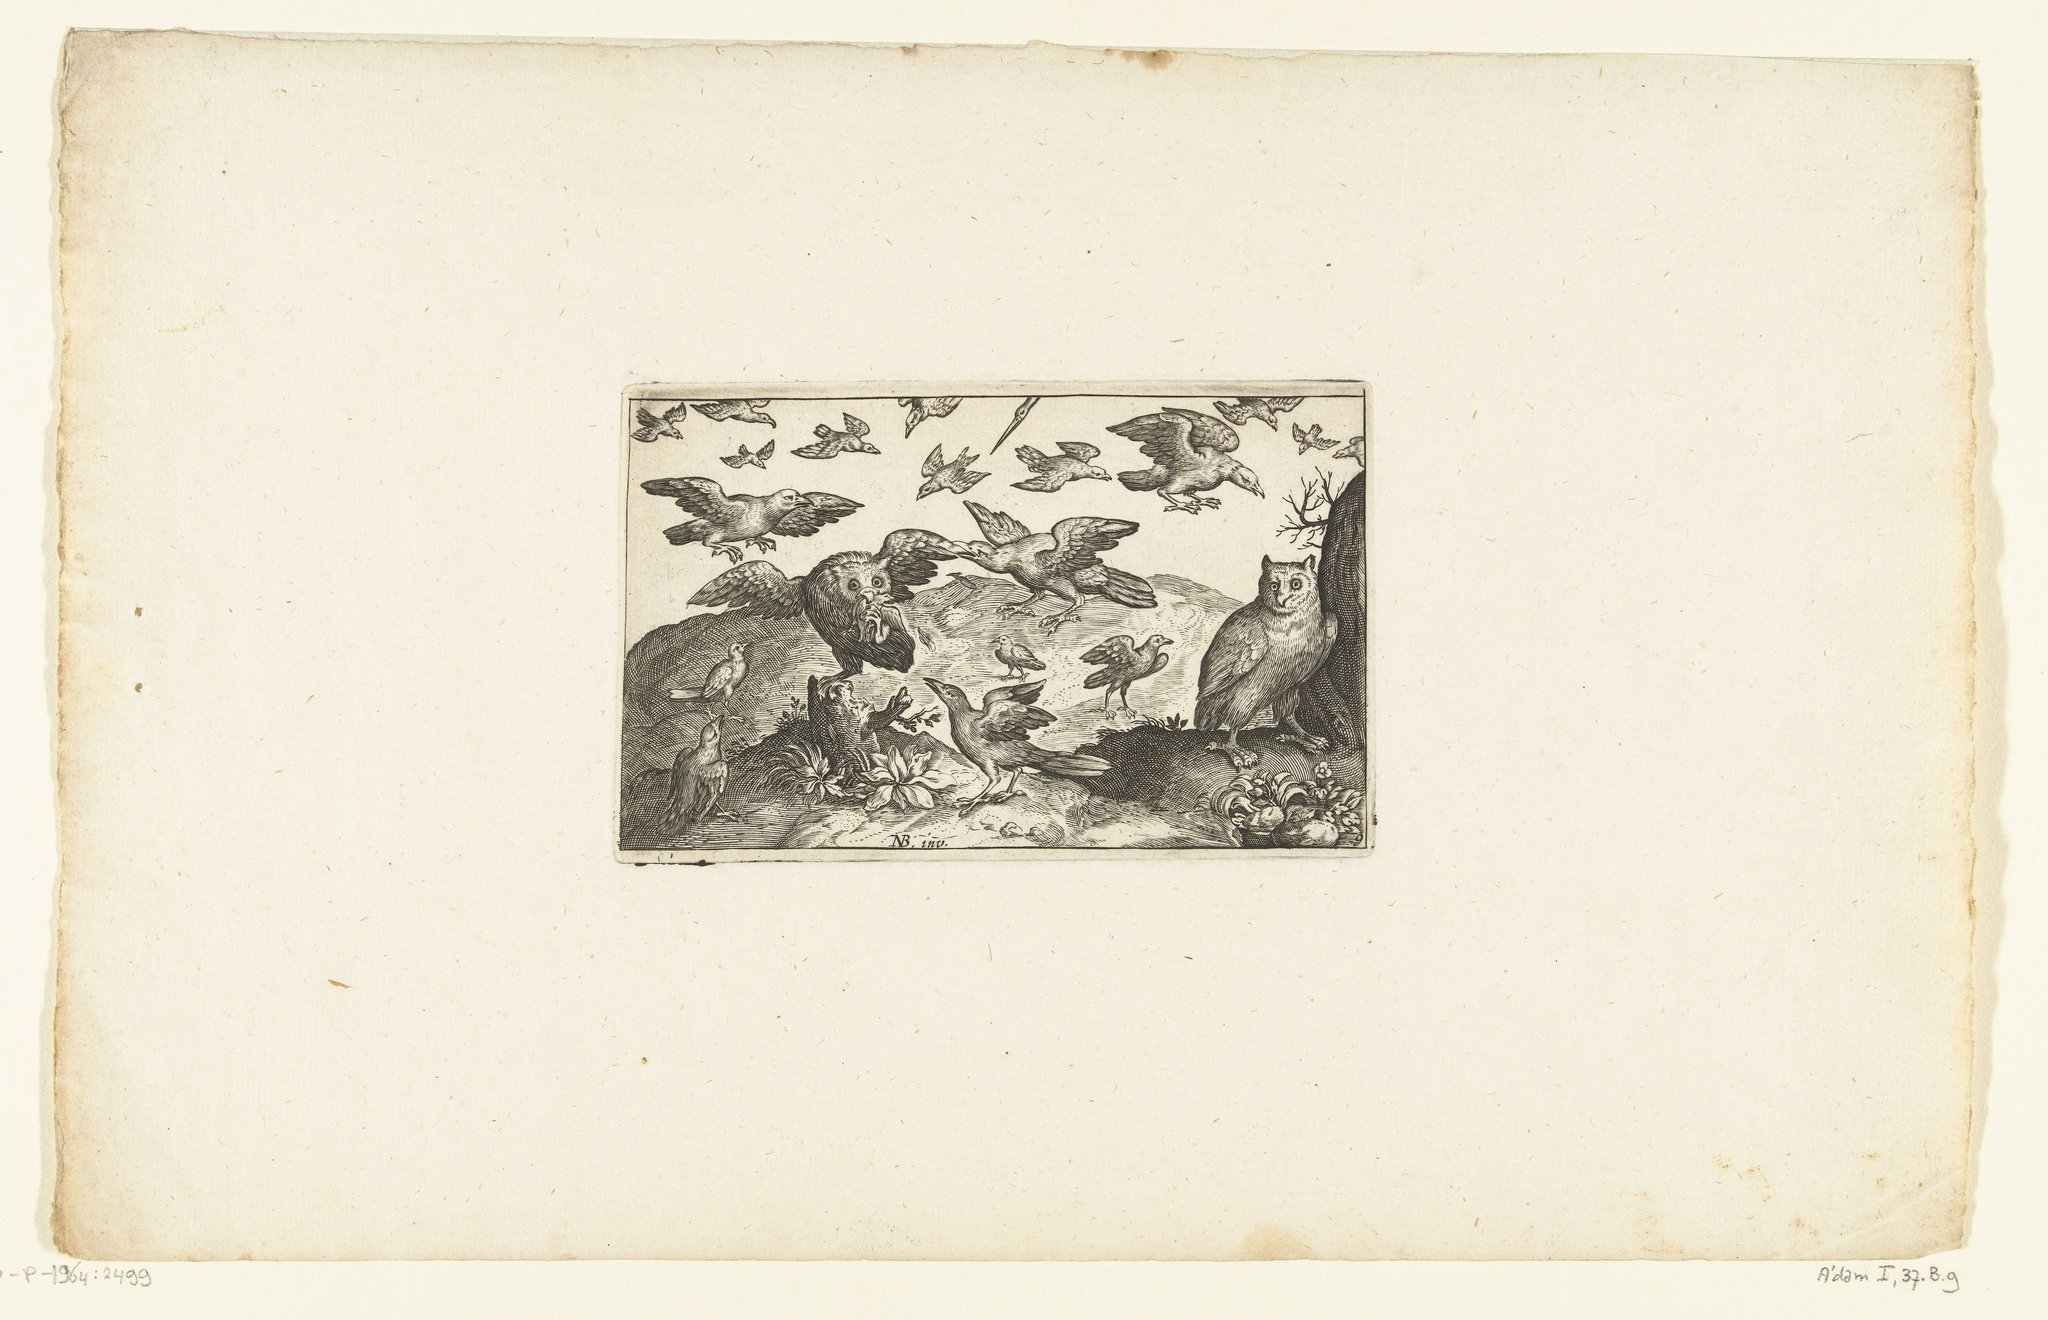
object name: print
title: Staande uil en uil die belaagd wordt door vogels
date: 1581-1652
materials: paper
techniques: engraving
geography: amsterdam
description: Rechts een staande uil. Links een uil die een jong vogeltje heeft gevangen en belaagd wordt door andere vogels.Tegenzijdige kopie naar prent uit de serie beschreven bij Orn Cat I-37.8